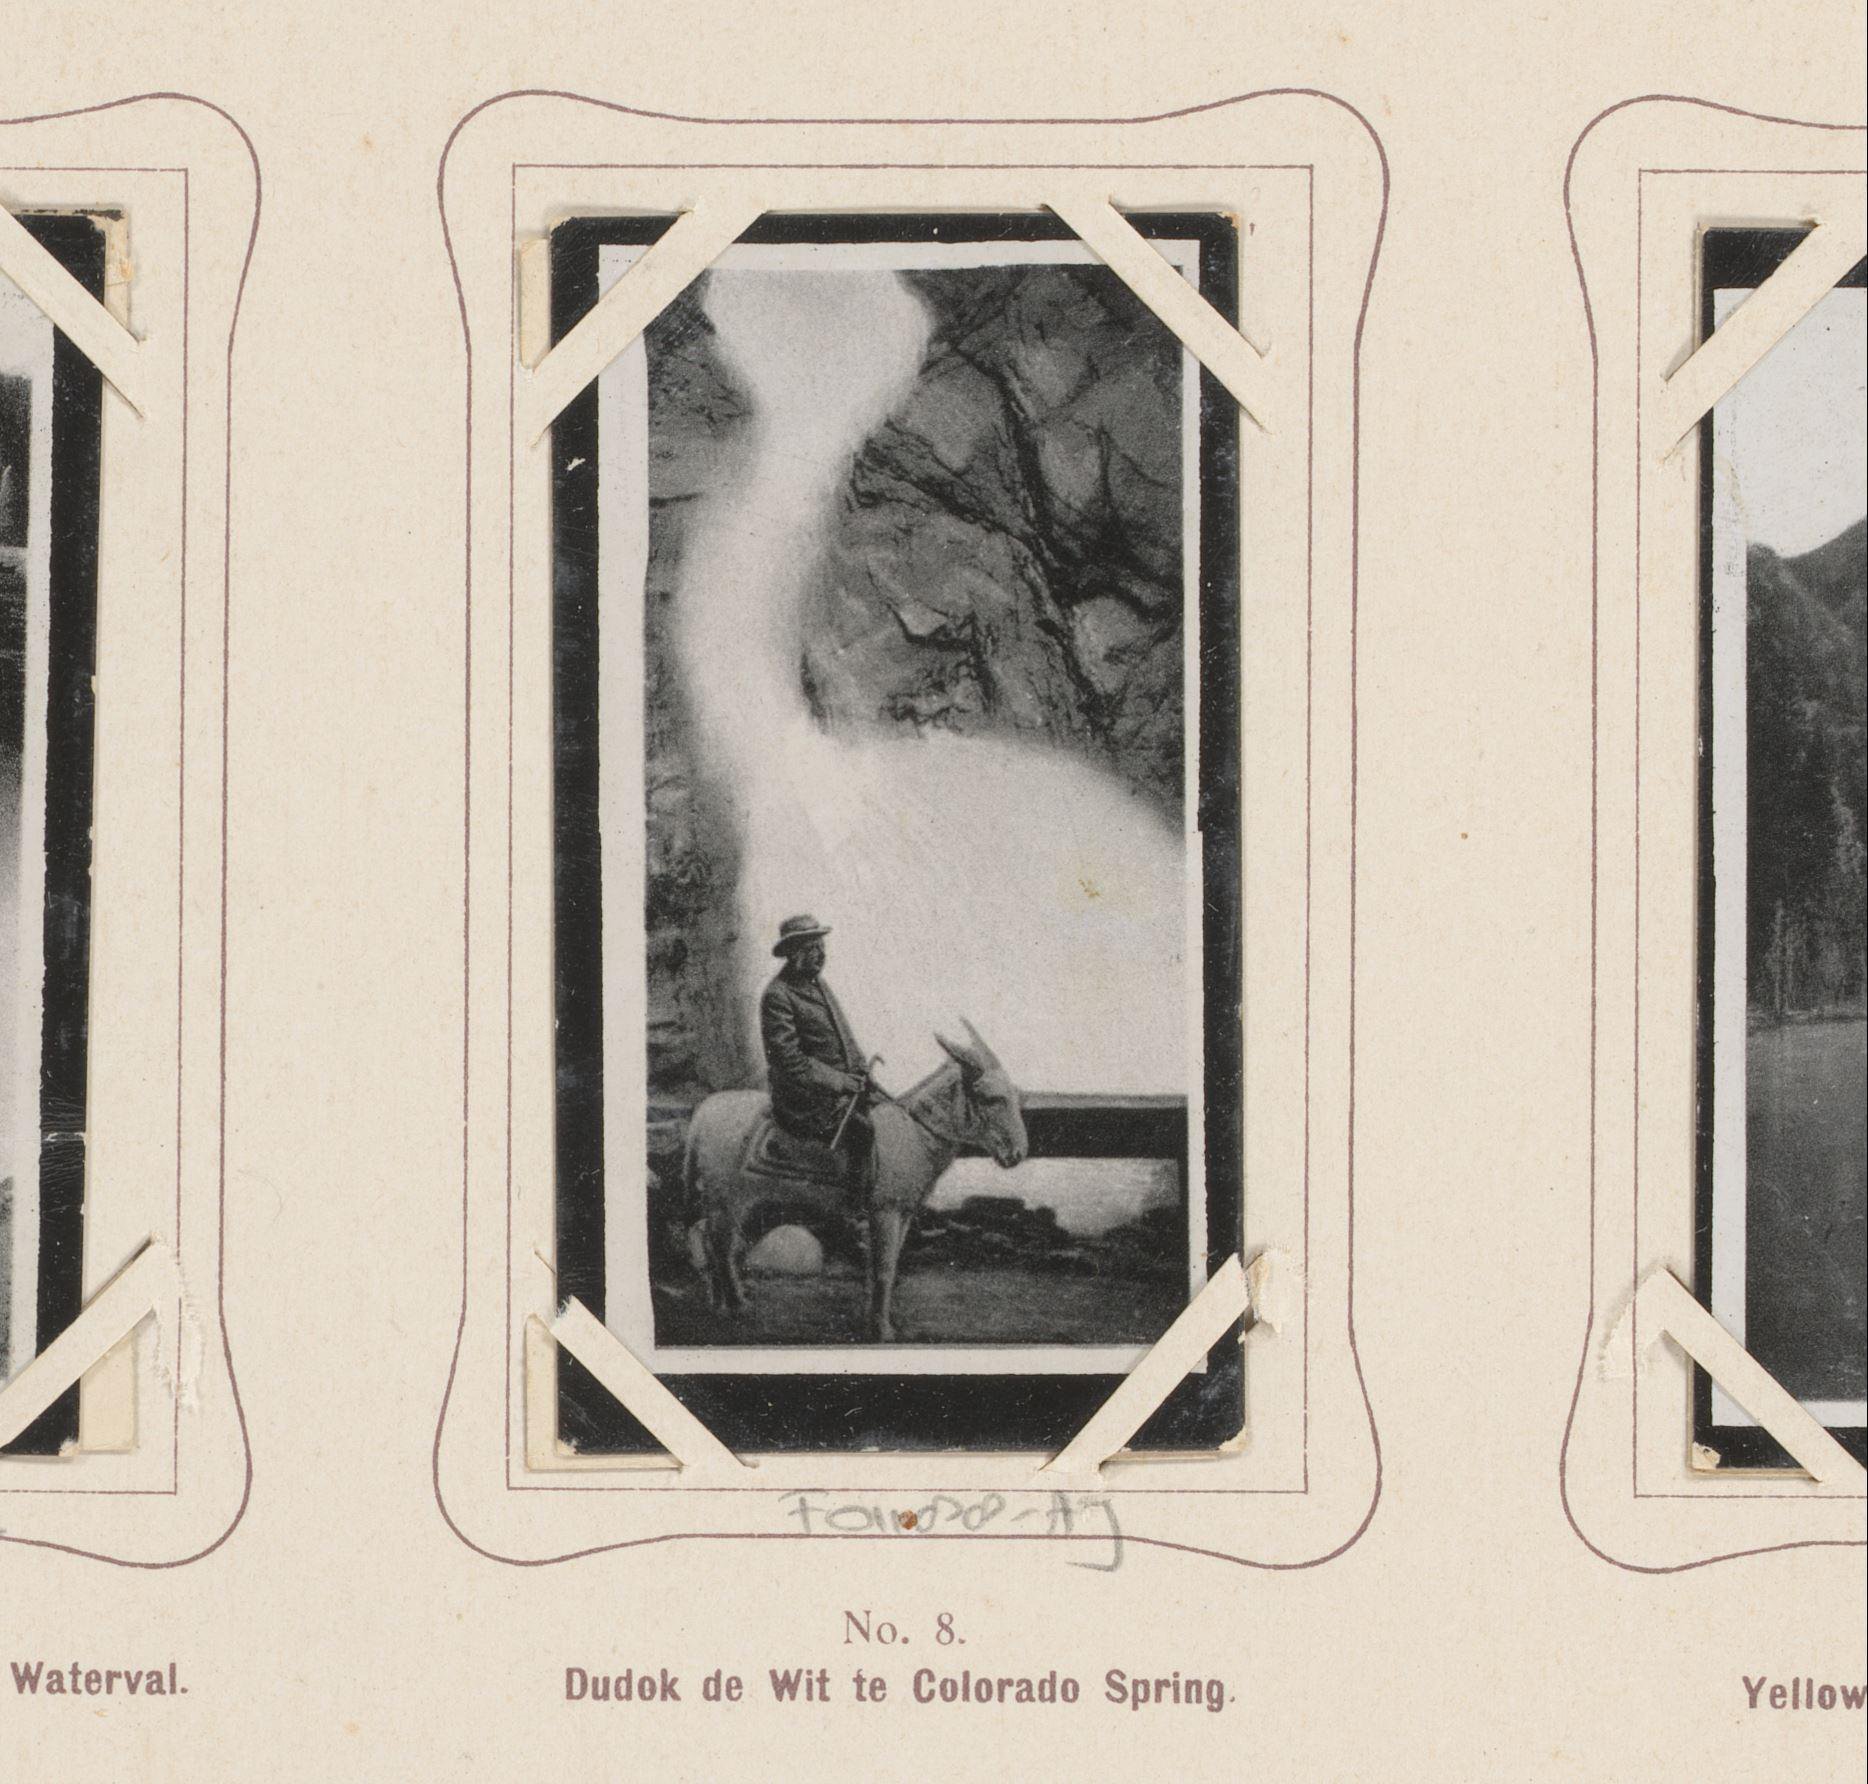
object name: album leaf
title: Leonard Corneille Dudok de Wit bij een waterval te Colorado Springs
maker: Anonymous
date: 1906-1907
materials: paper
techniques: photograph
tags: amsterdam, waterfall, historical persons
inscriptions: inscription: ‘No. 8./ Dudok de Wit te Colorado Spring.’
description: Deze prent maakt deel uit van een album.